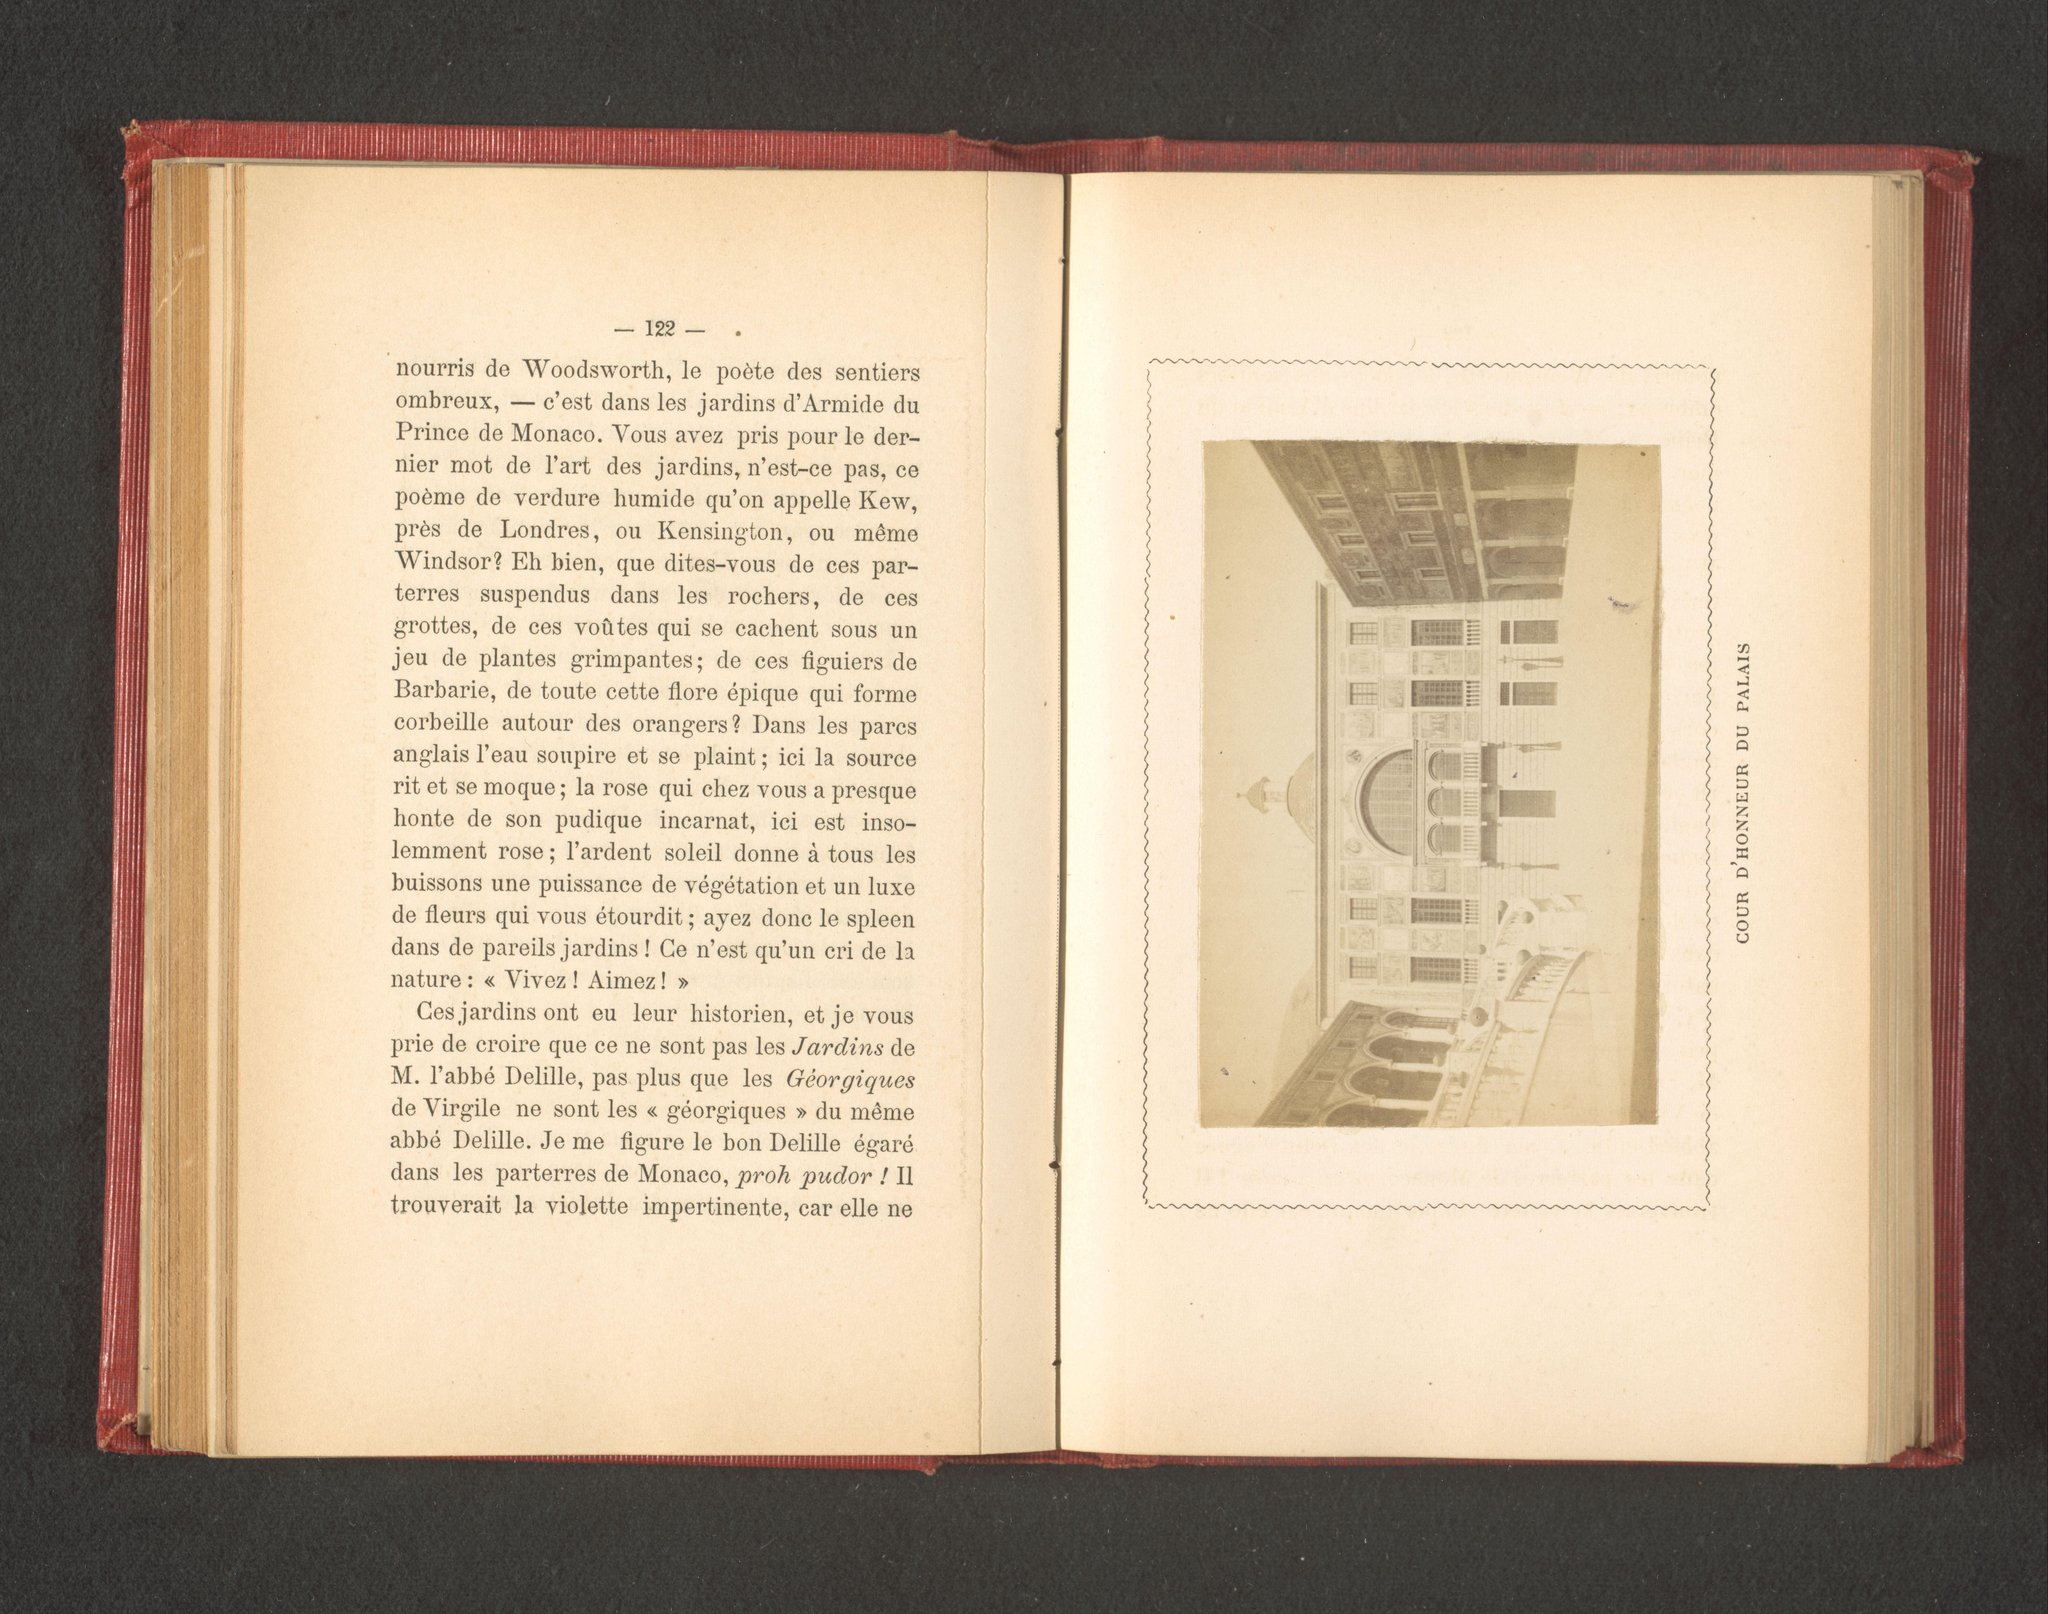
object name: photograph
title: Gezicht op de binnenplaats van het prinselijk paleis van Monaco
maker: Anonymous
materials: photographic support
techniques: albumen print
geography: monaco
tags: palace, courtyard